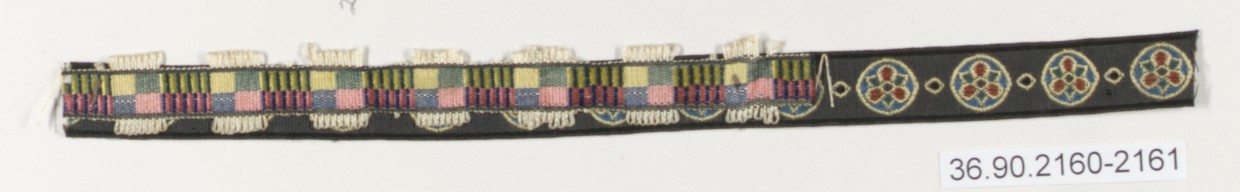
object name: piece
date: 1801-1900